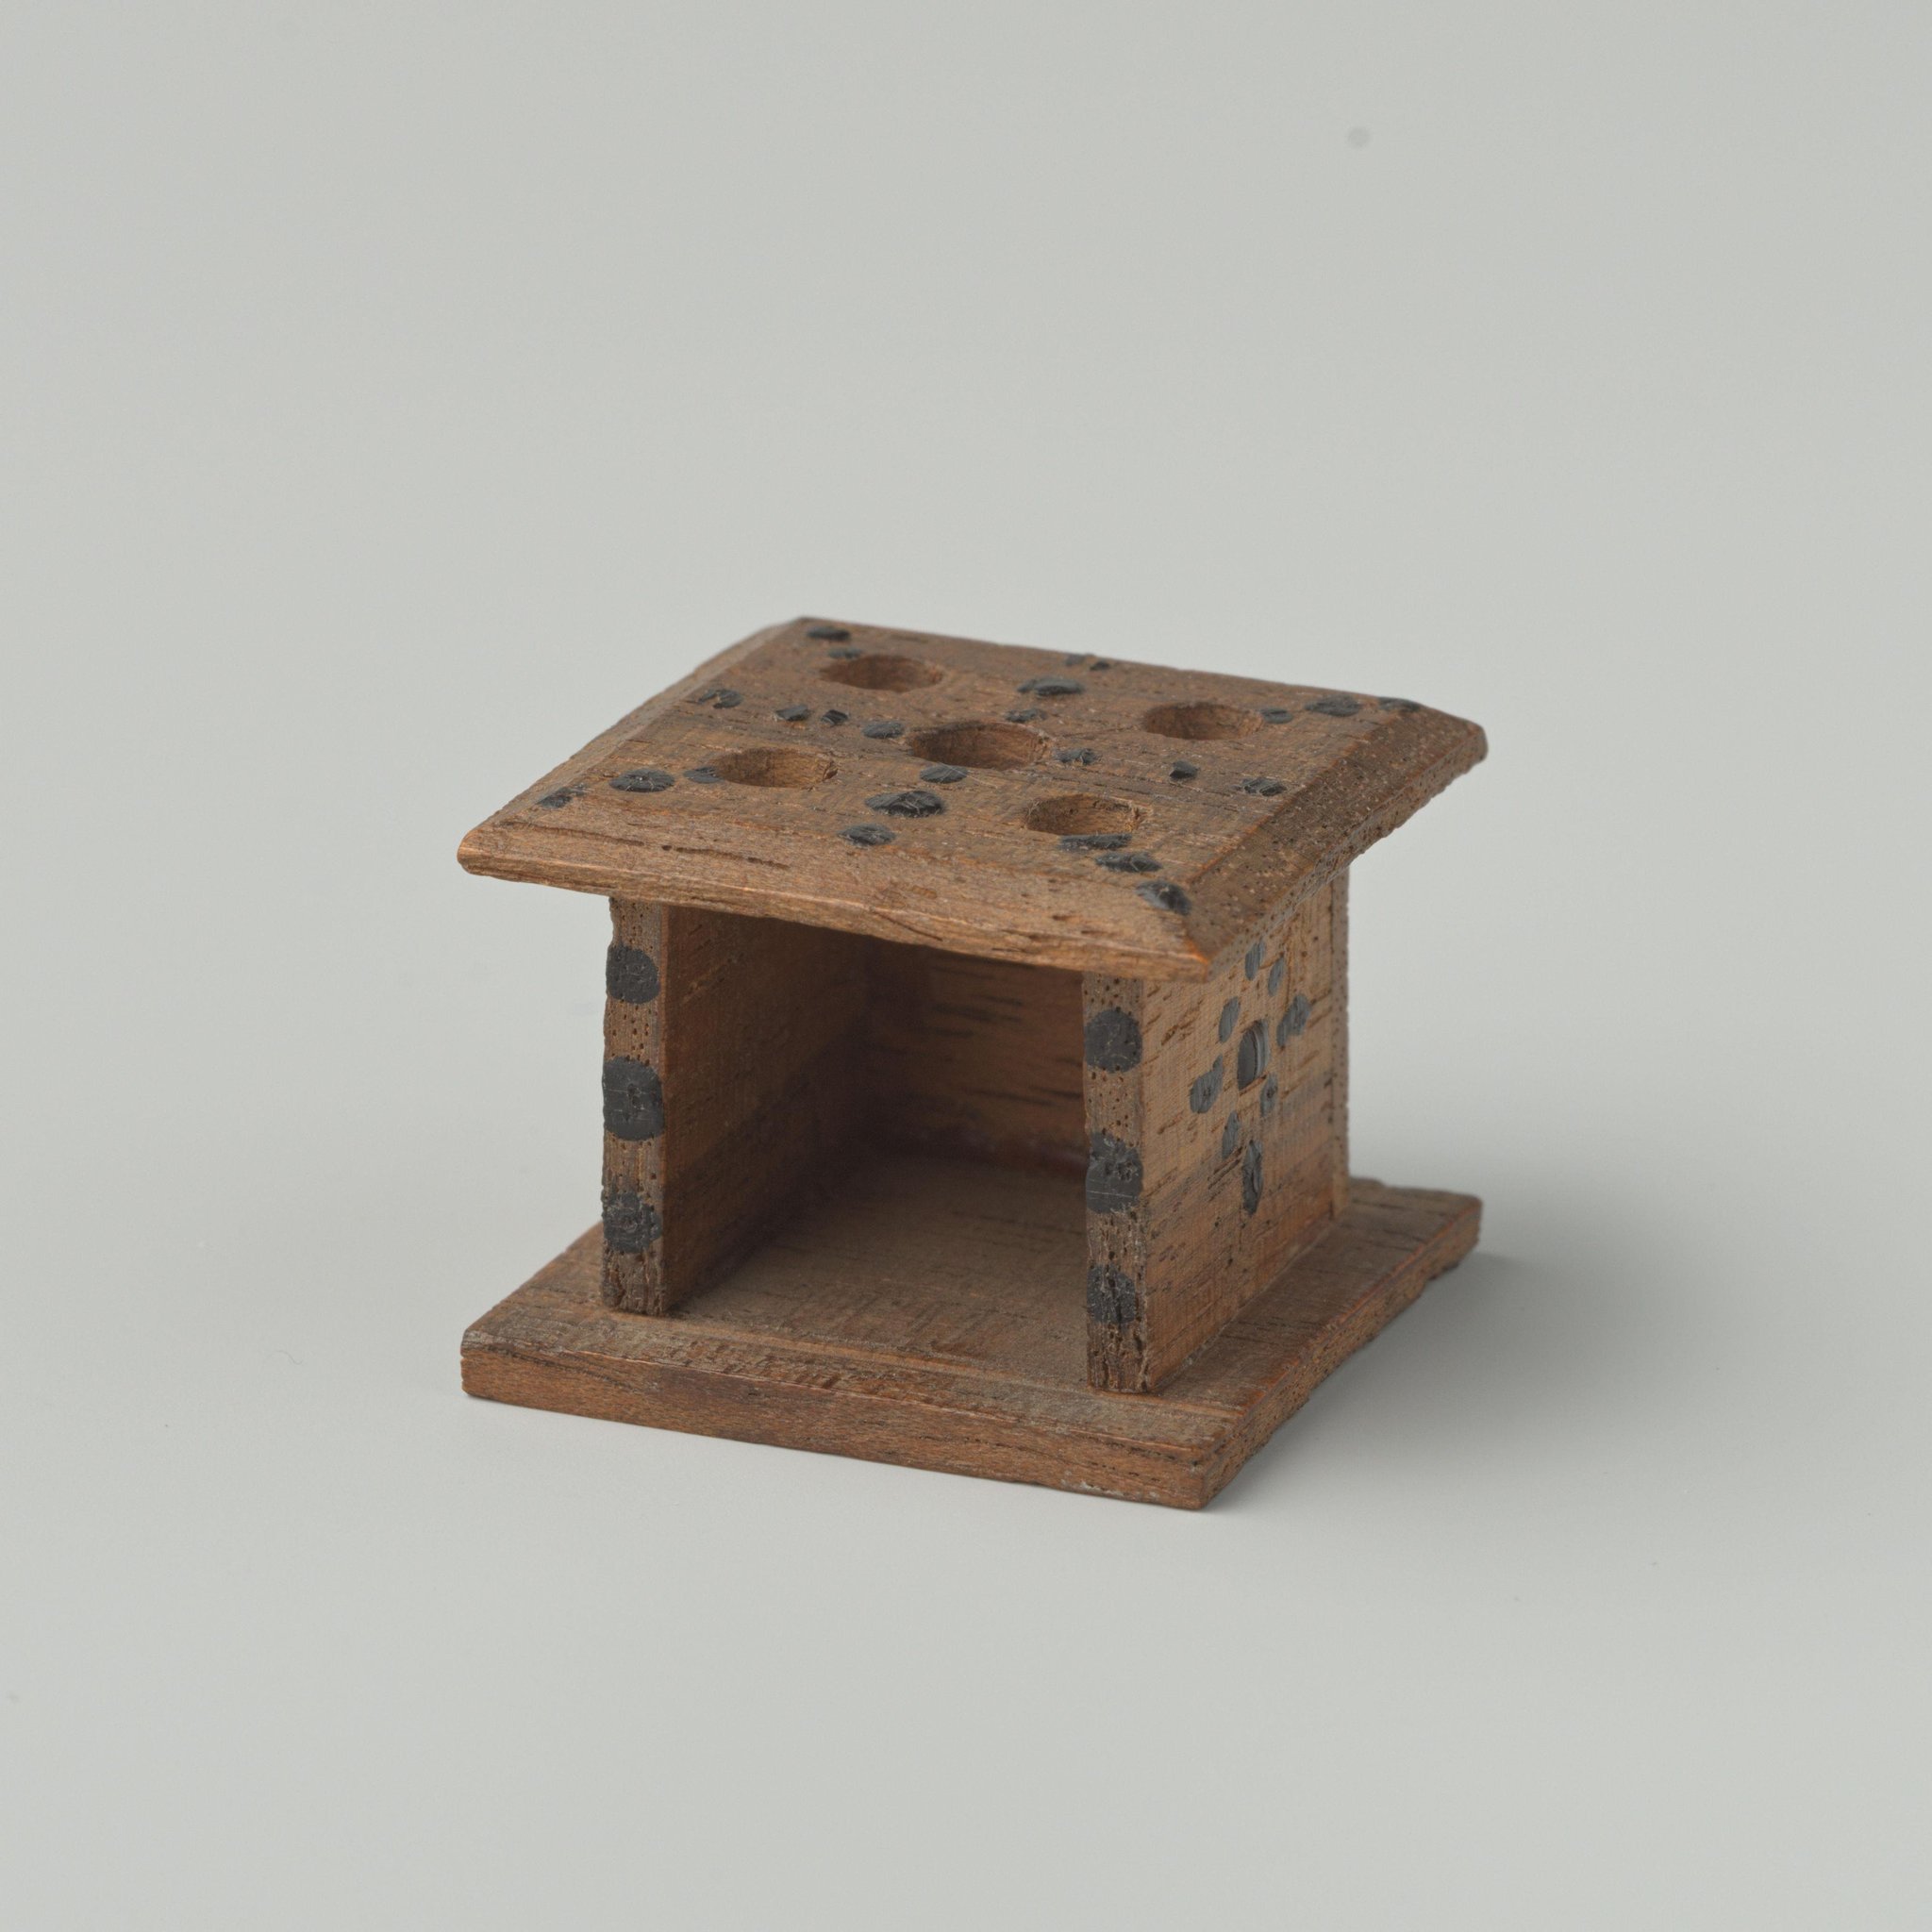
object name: voetstoof, stoof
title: Stoof van notenhout, versierd met zwarte stippen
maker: Anonymous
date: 1676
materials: wood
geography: amsterdam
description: Stoof van notenhout, vierkant, versierd met zwarte stippen. In de voetenplank zijn vijf gaten aangebracht.